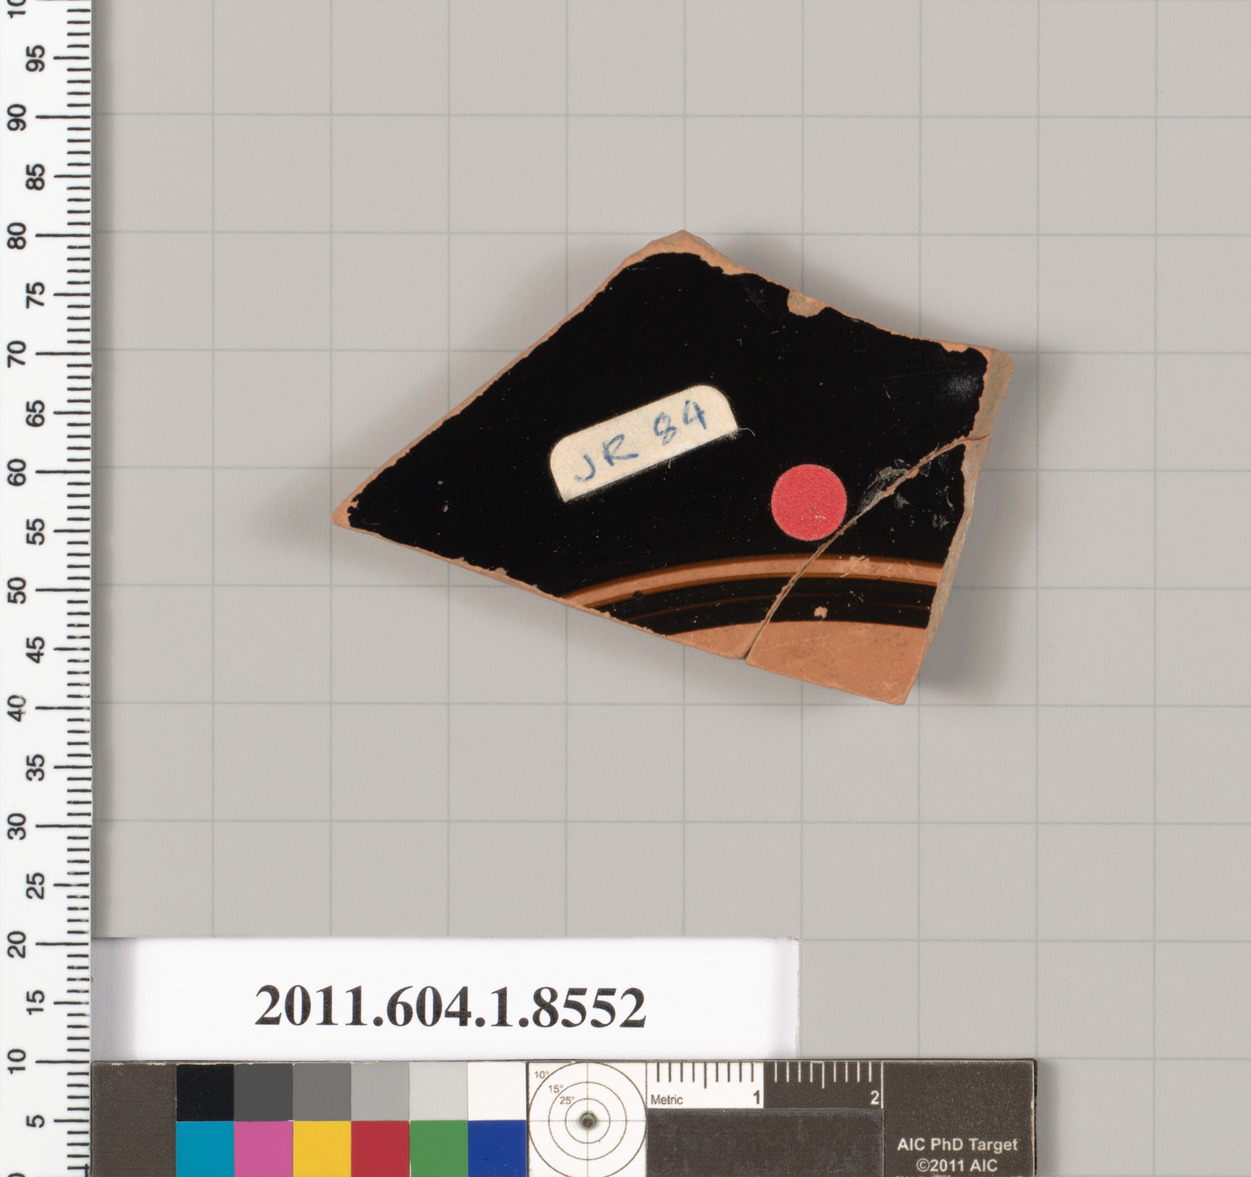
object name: kylix fragment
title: Terracotta fragment of a stemless kylix (drinking cup)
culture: greek, attic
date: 470-450 BCE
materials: terracotta